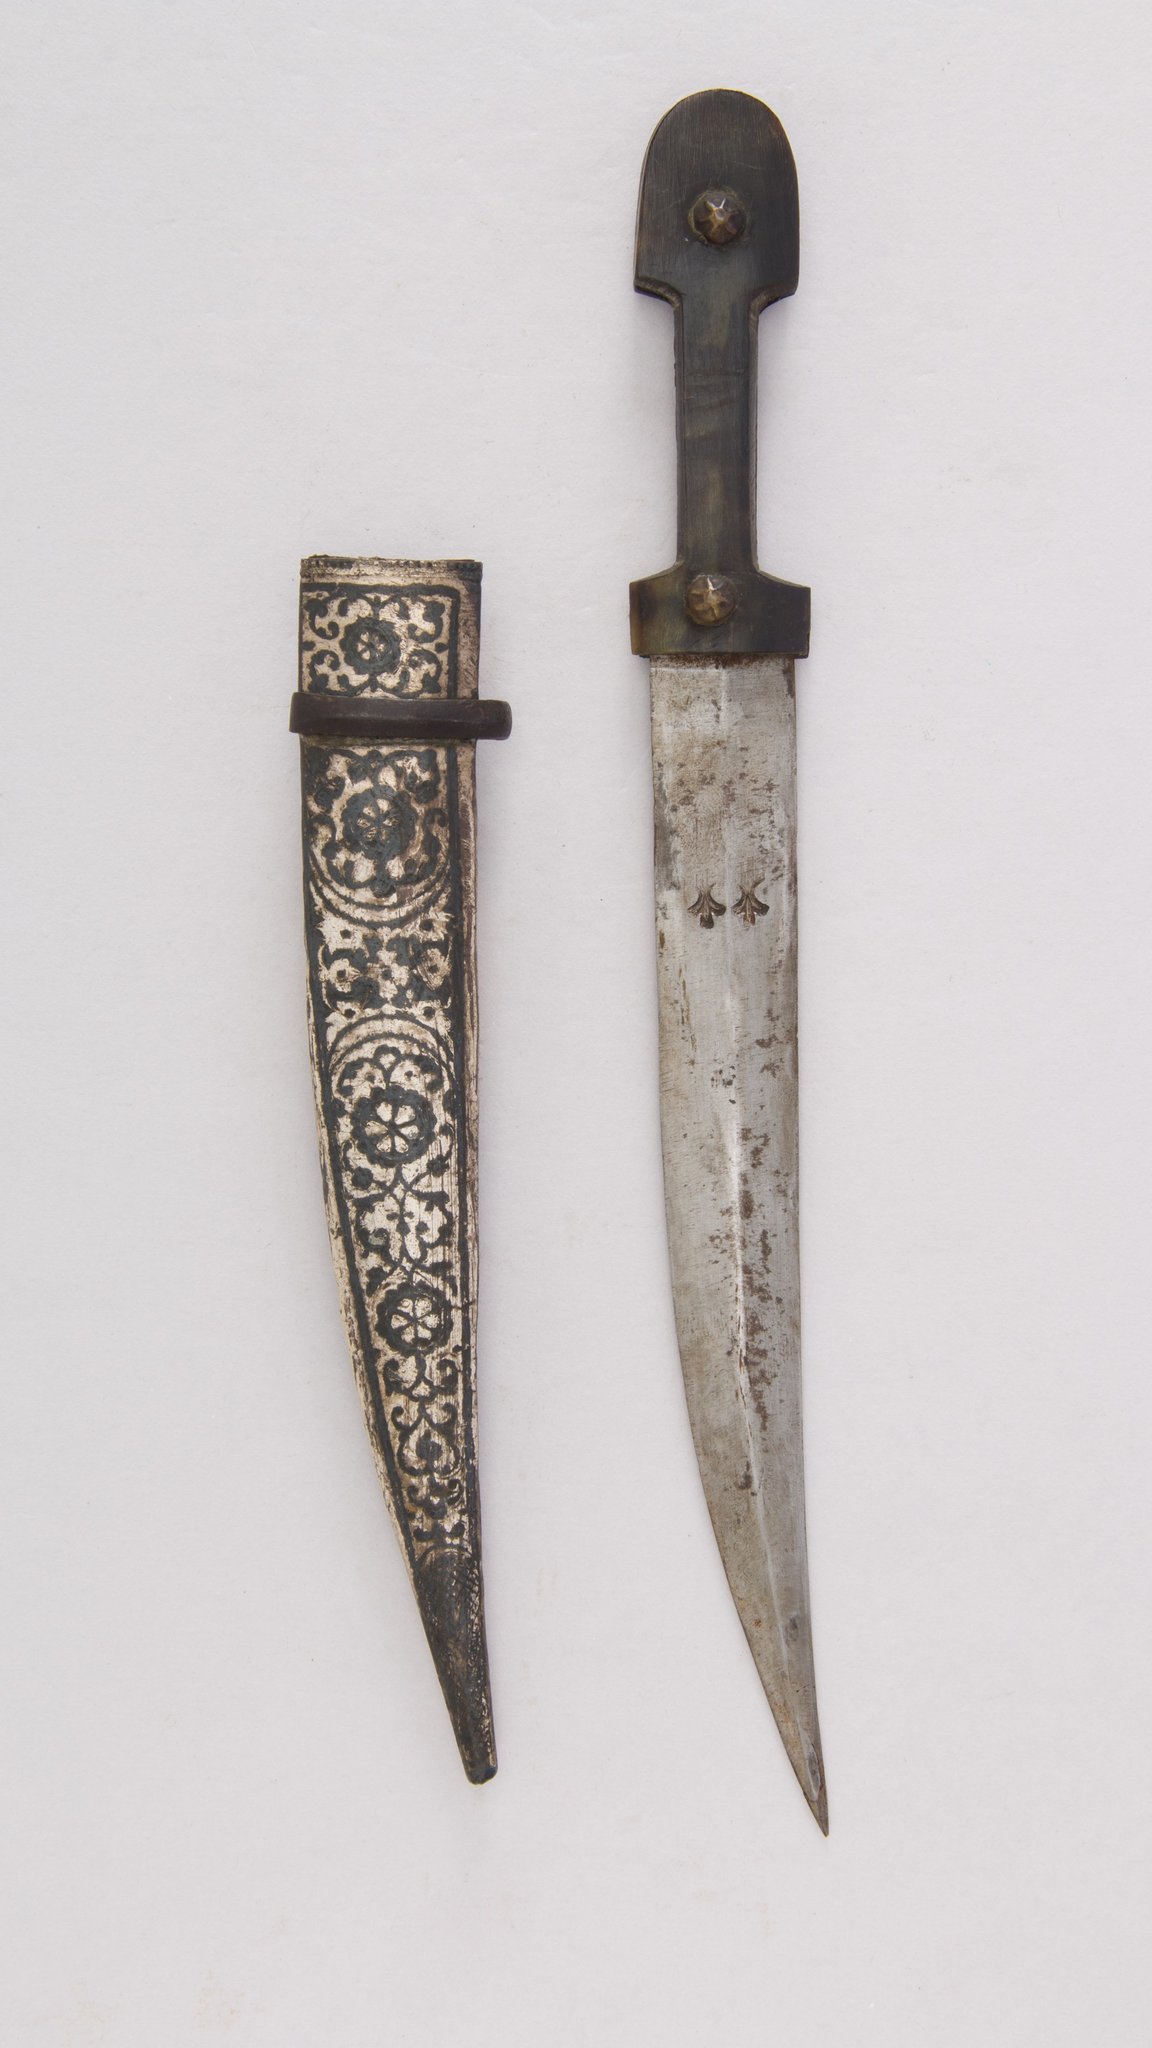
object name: dagger kindjal with sheath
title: Dagger (Kindjal) with Sheath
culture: circassian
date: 1701-1900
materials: brass, horn, iron, silver, steel, textile, wood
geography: north caucasus